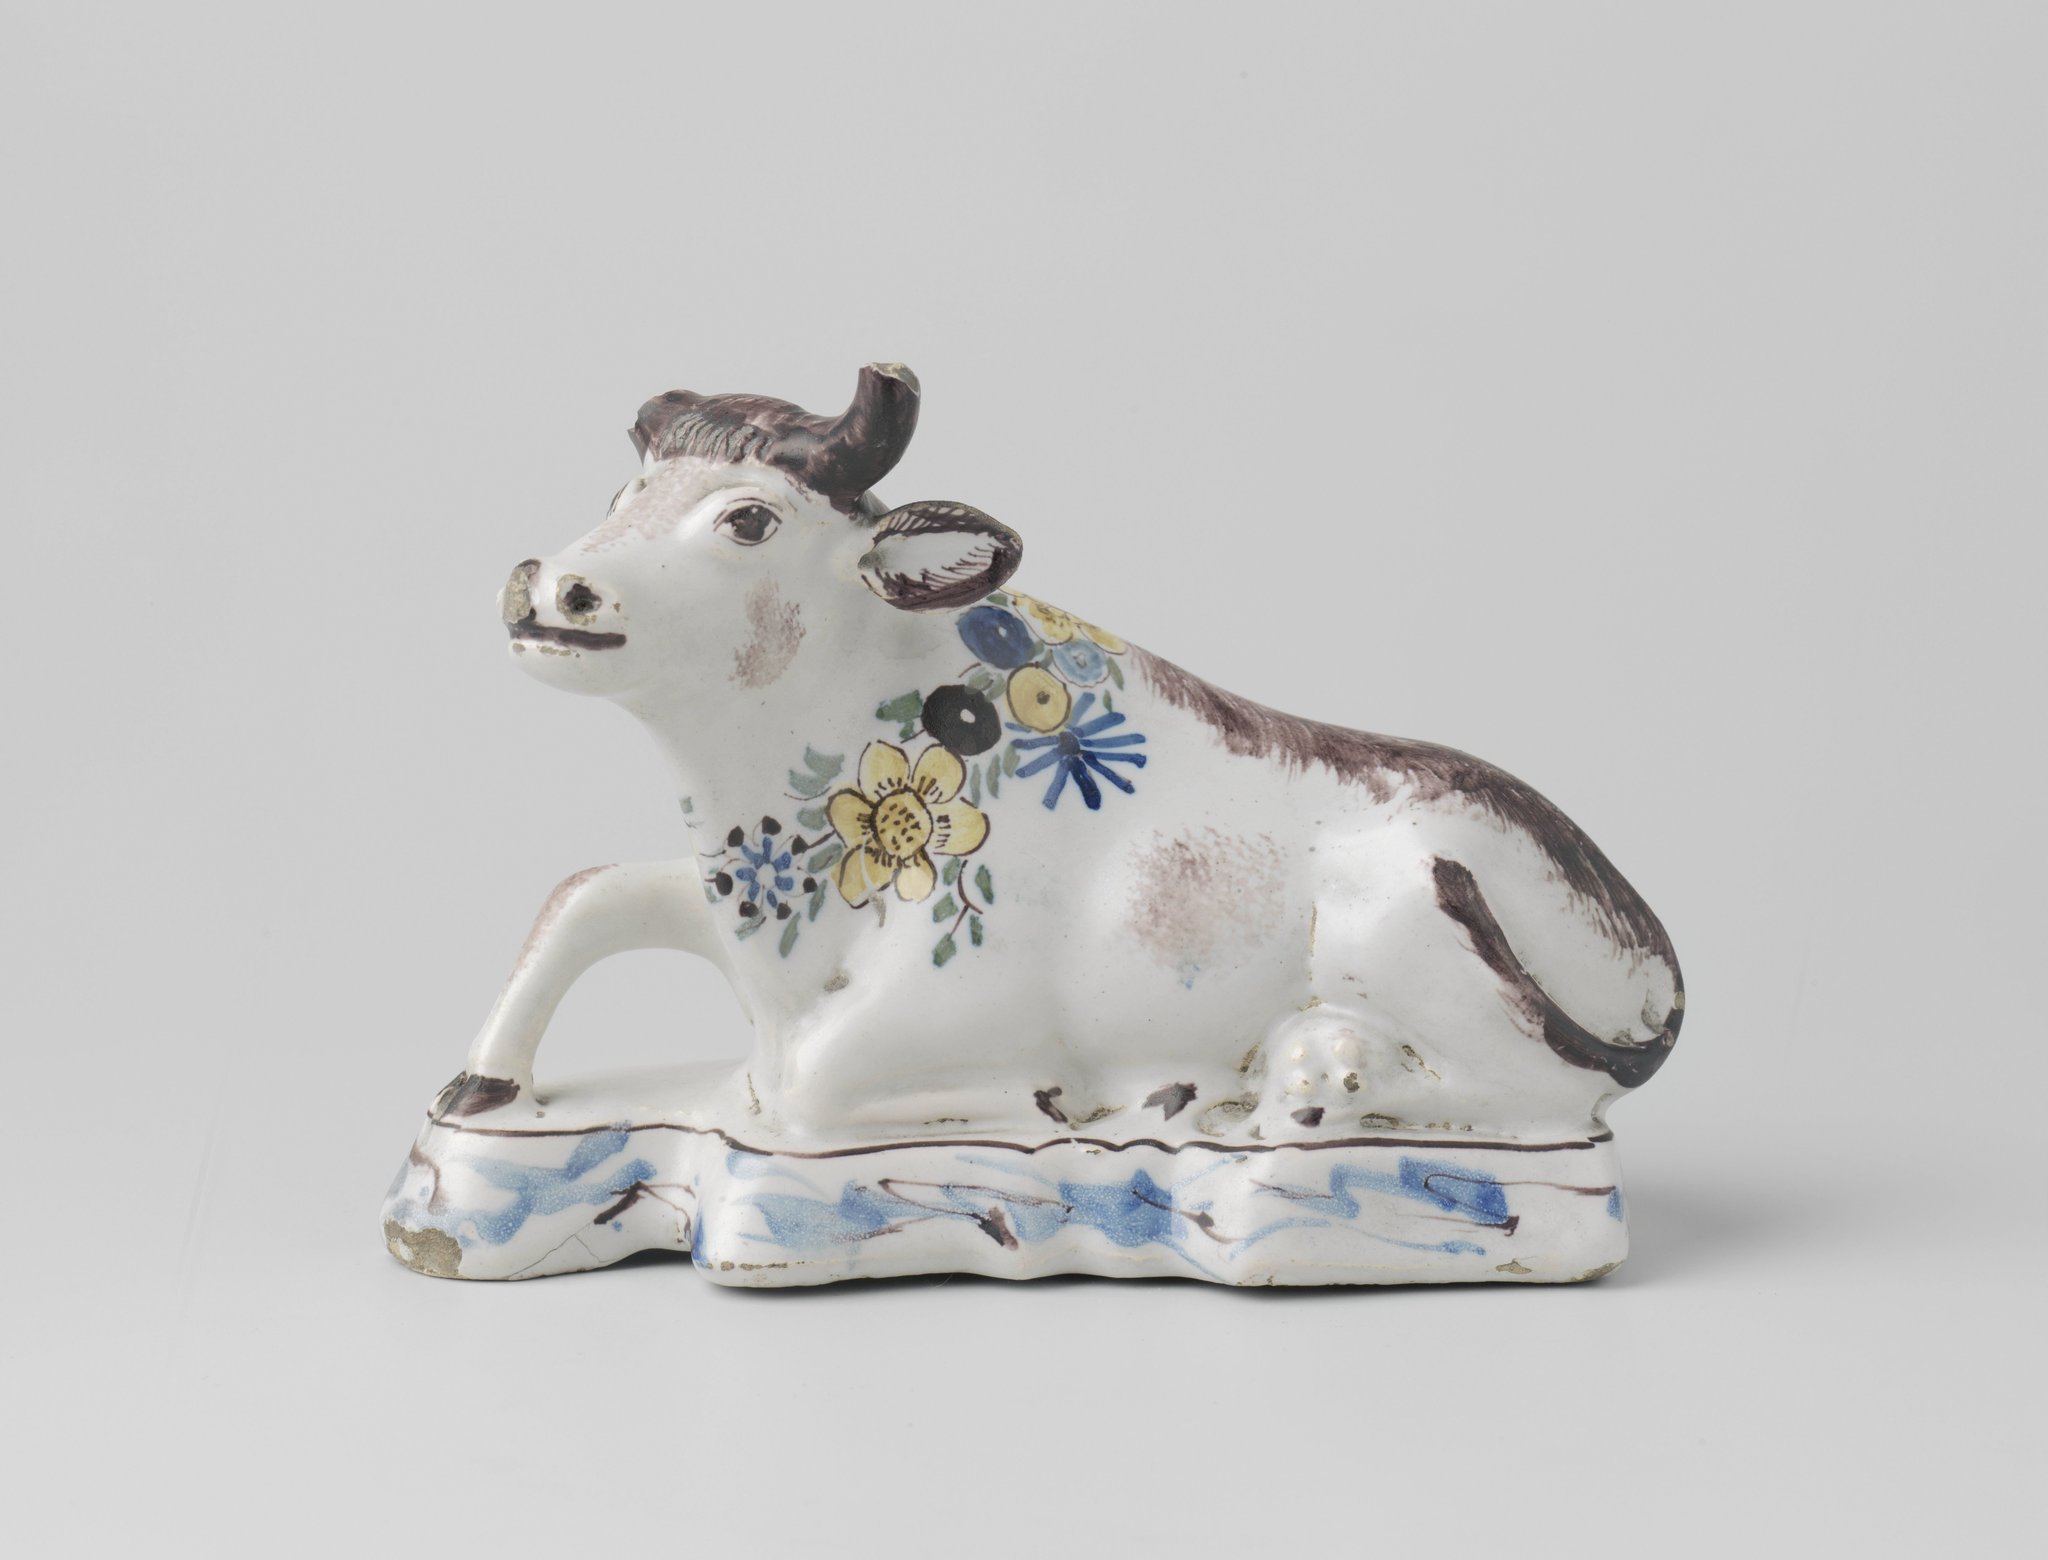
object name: decoratief object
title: Koe, liggend, veelkleurig beschilderd.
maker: Anonymous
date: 1770-1820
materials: earthenware, glaze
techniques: painted, polychromy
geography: amsterdam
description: Liggende koe van veelkleurig beschilderde faience.